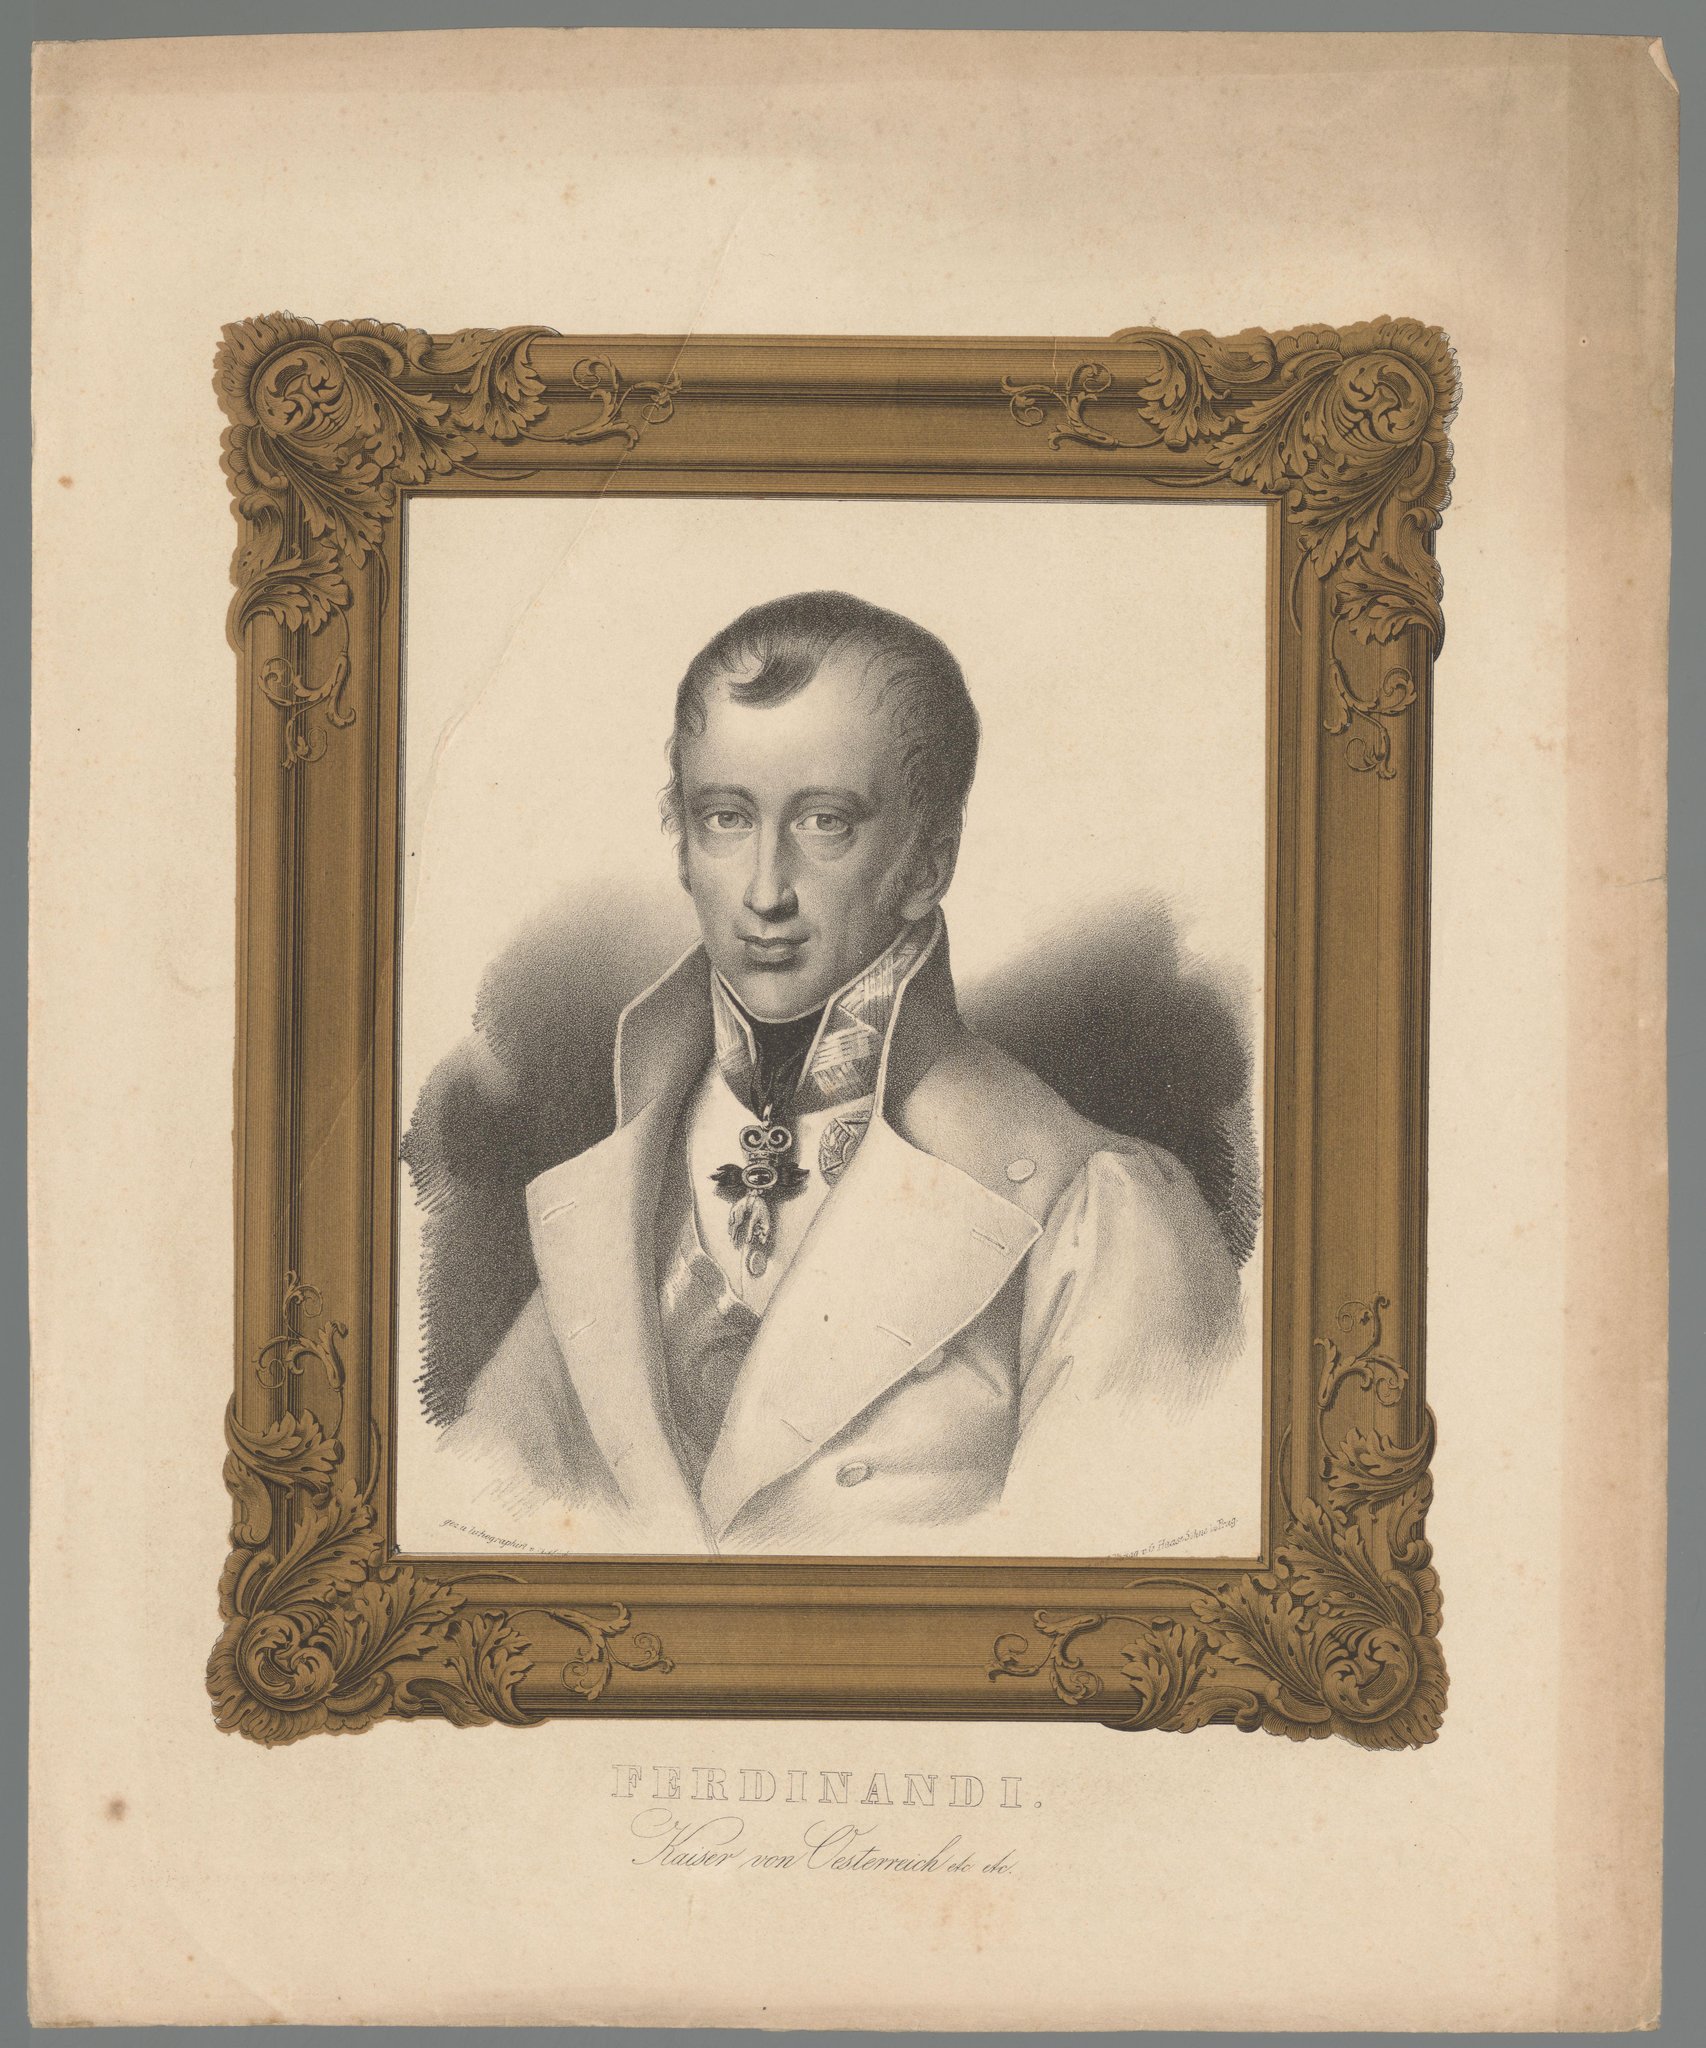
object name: print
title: Portret van Ferdinand I van Oostenrijk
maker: josef vojtech hellich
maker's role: painter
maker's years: 1810-1880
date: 1820-1880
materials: paper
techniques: lithograph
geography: prague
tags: vienna, prague, ferdinand i (keizer van oostenrijk), historical persons, emperor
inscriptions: collector's mark: Lugt 2228